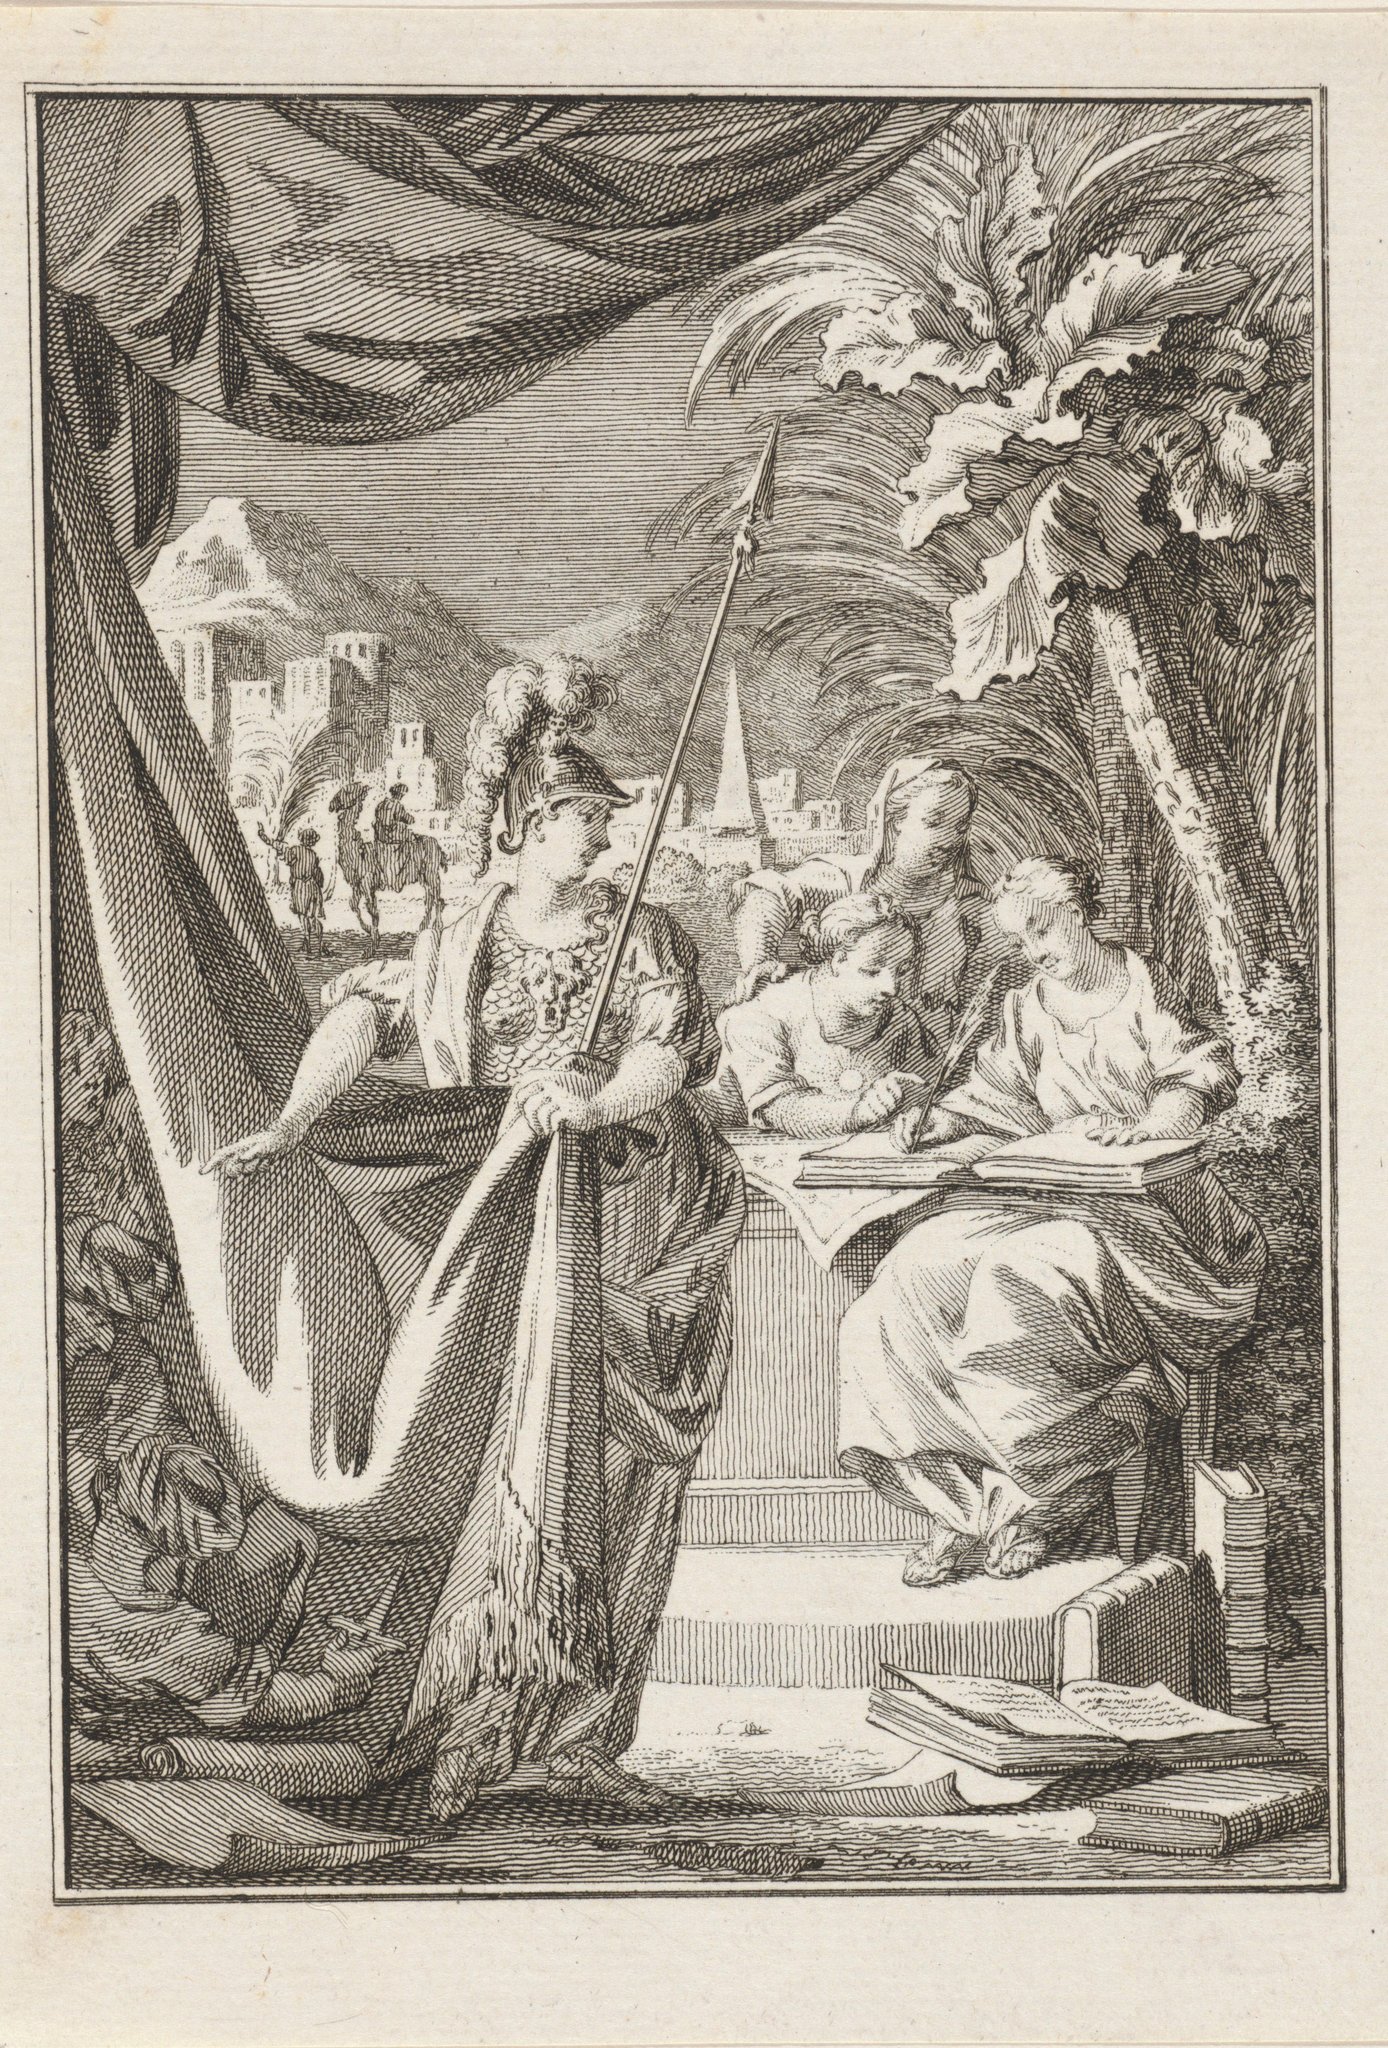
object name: print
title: Titelpagina voor: 'Hedendaagsche Historie der Arabieren, deel 2', 1765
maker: reinier vinkeles (i)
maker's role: draughtsman, print maker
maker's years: 1741-1816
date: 1765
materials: paper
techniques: etching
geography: amsterdam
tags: handwriting, writing as activity, (story of) minerva (pallas, athena), head-gear: turban, book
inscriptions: collector's mark: Lugt 240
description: Proefdruk van titelpagina voor: Hedendaagsche historie; of Het vervolg van de Algemeene historie (...). IIde deel (...) behelzende het vervolg van de historie der Arabieren. Amsterdam: Gerrit de Groot en Zoon, Kornelis van Tongerlo en Petrus Schouten, Leiden: Pieter van der Eyk, 1765.